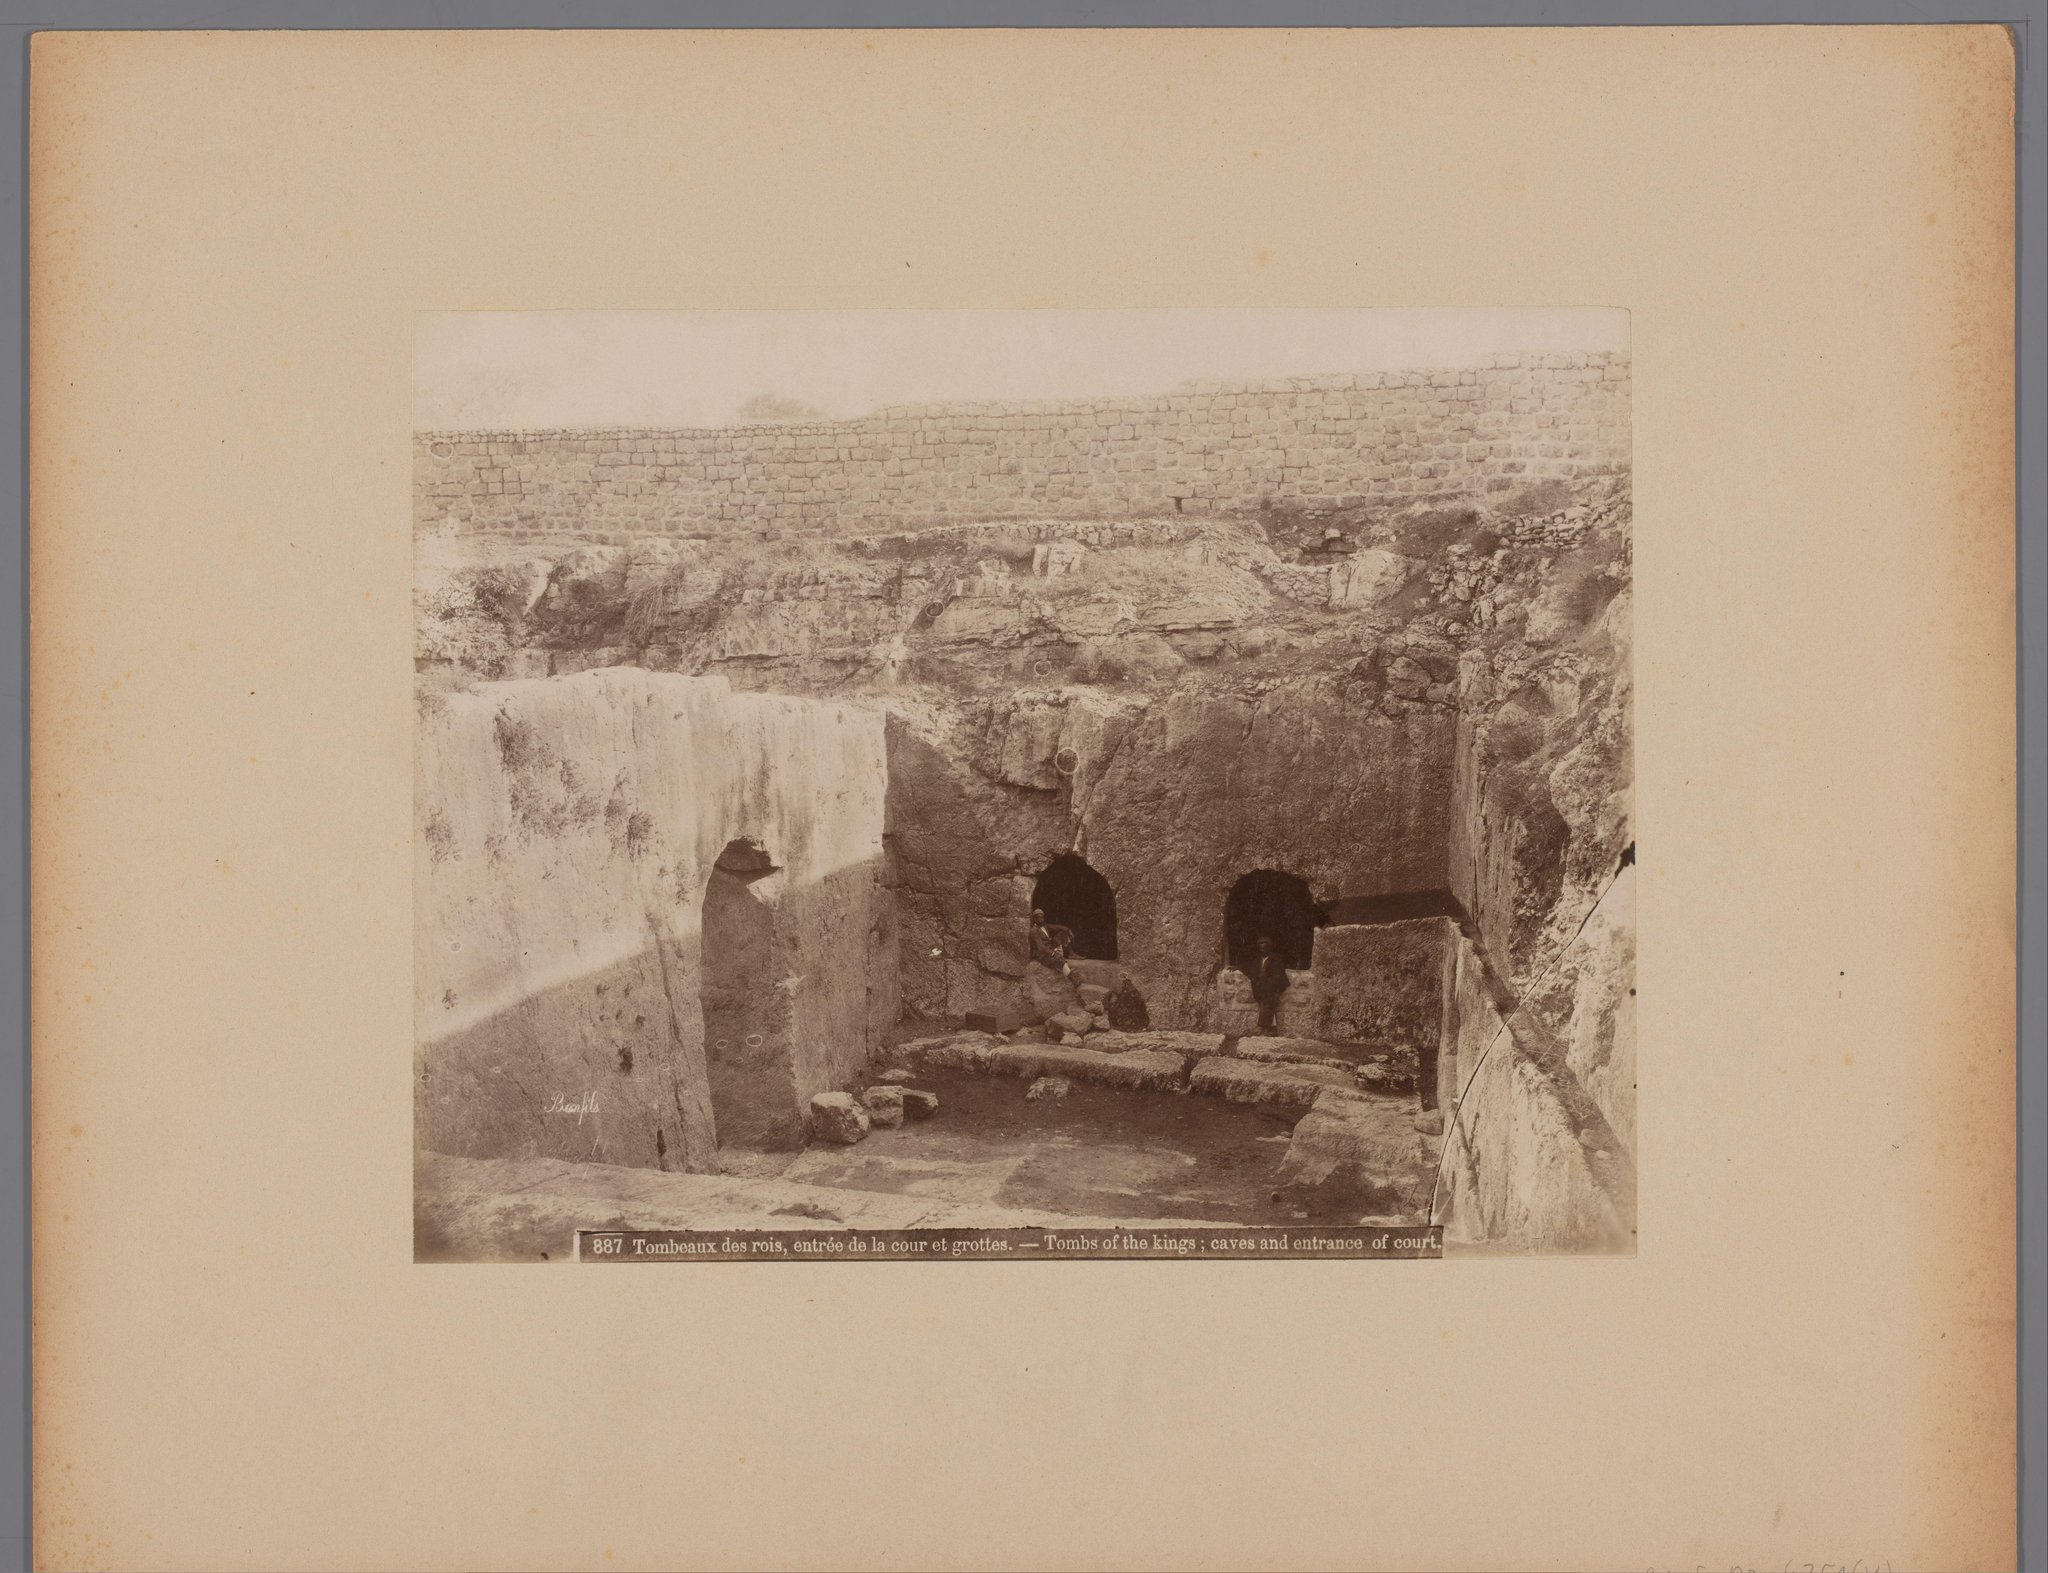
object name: photograph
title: Graftomben van de koningen ["Tombeaux des rois, entrée de la cour et grottes/Tombs of the kings; caves and entrance of court"], Jeruzalem, Palestina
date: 1850-1900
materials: cardboard, photographic support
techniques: albumen print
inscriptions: inscription: ‘887 Tombeaux des rois, entrée de la cour et grottes. - Tombs of the kings ; caves and entrance of court’, inscription: ‘Bonfils’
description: Ingang en Mikvah [?] = ritueel bad]. Laatste rustplaats van (de familie van) Koningin Helene van Adiabene in de eerste eeuw n. Chr. De graven liggen 820 meter van de oude stadmuur van Jeruzalem. De naamgeving als graf van de koningen komt voort uit het feit dat de ontdekkers dachten het graf van de leden van het koningshuis van David aan te treffen.